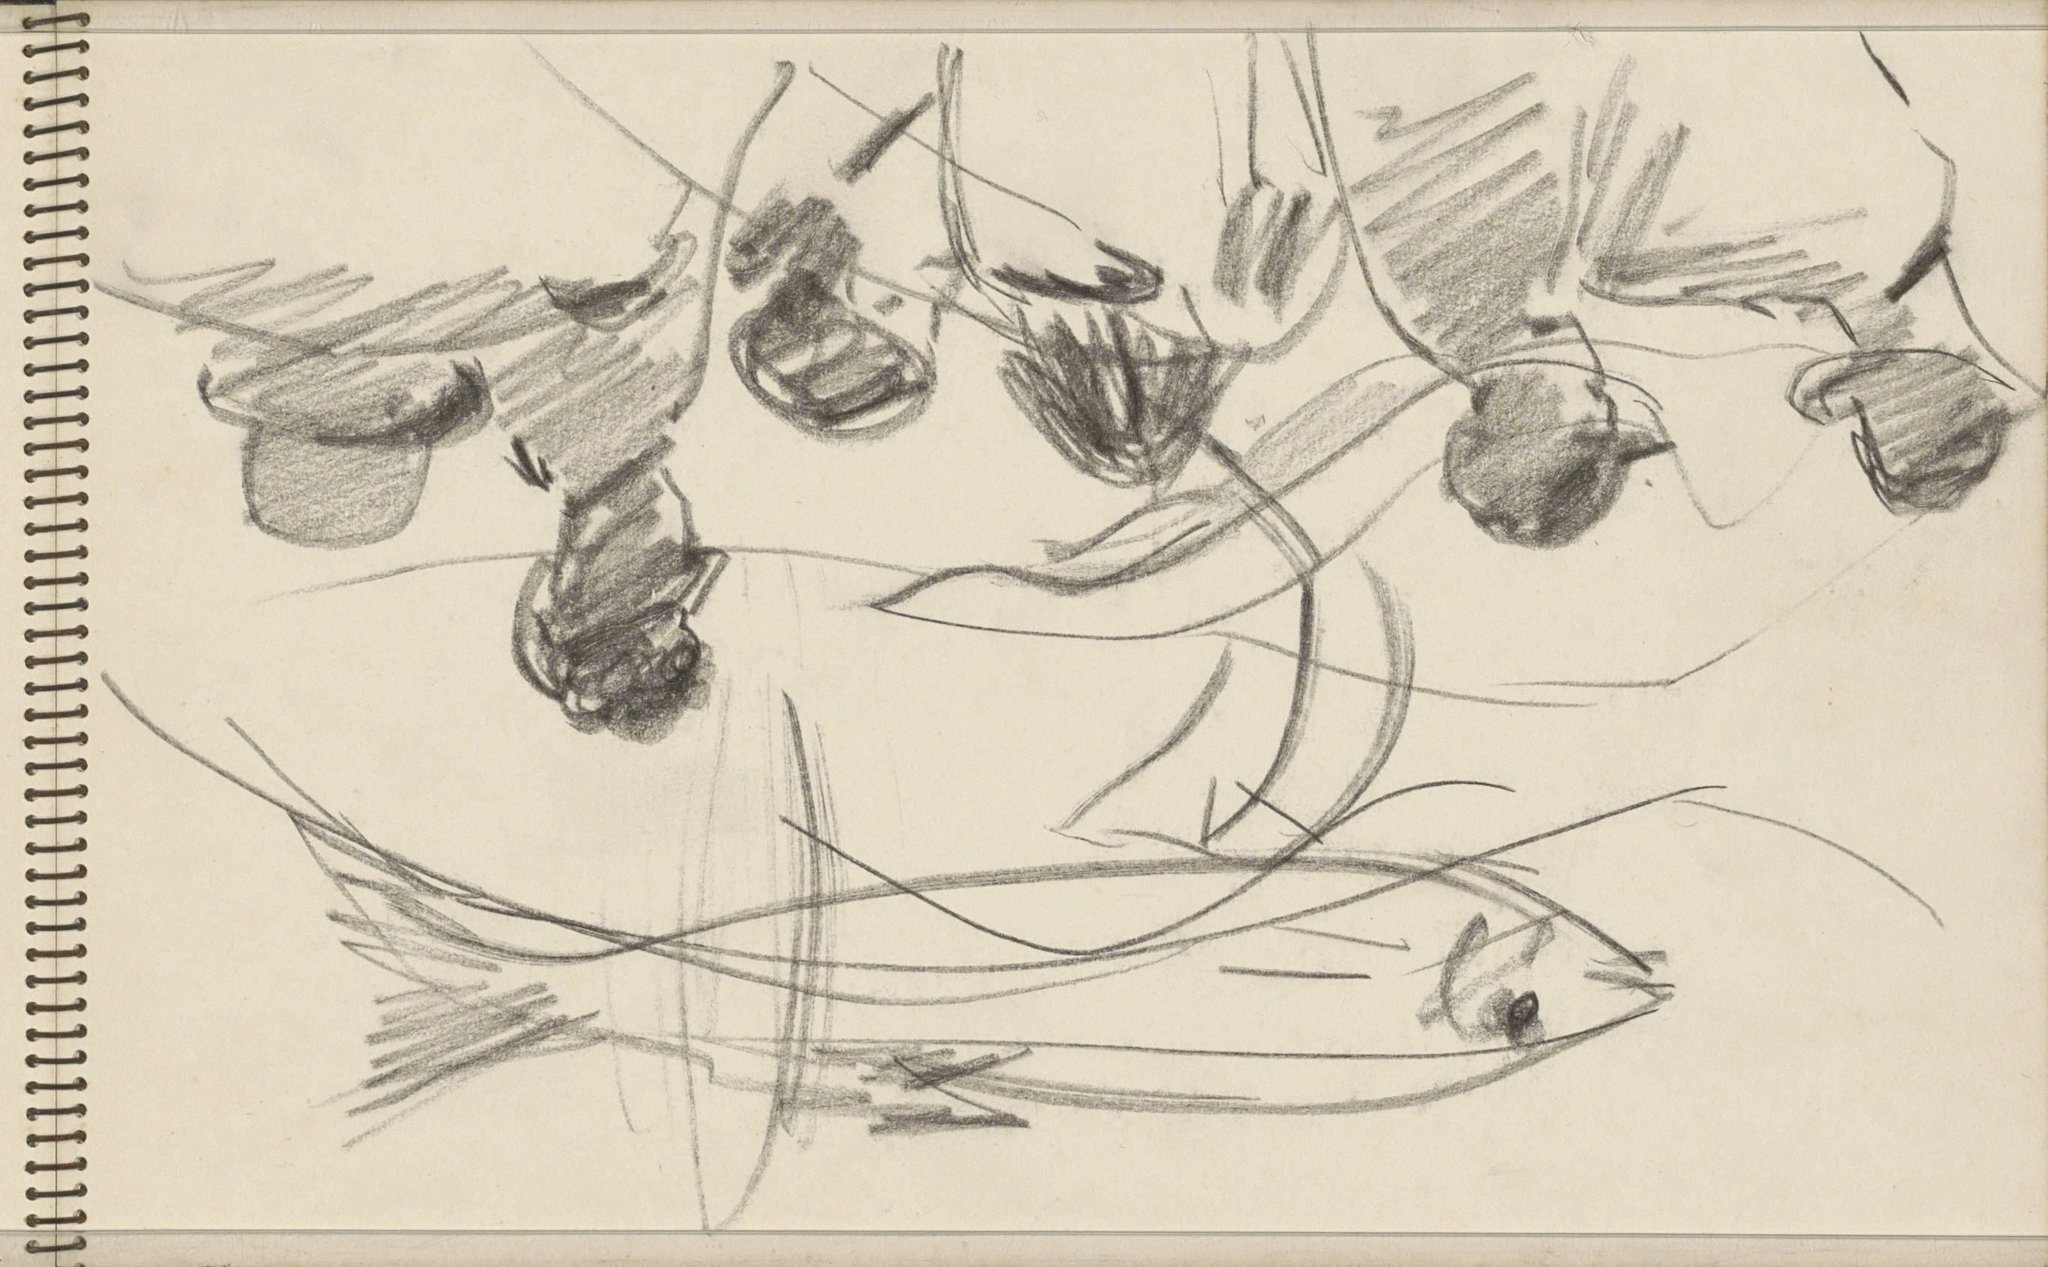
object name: sketchbook leaf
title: Vis en zes koppen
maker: carel adolph lion cachet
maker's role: draughtsman, print maker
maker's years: 1864-1945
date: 1930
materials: chalk, paper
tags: head (human), fishes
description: Blad 4 recto uit een schetsboek met 14 bladen.